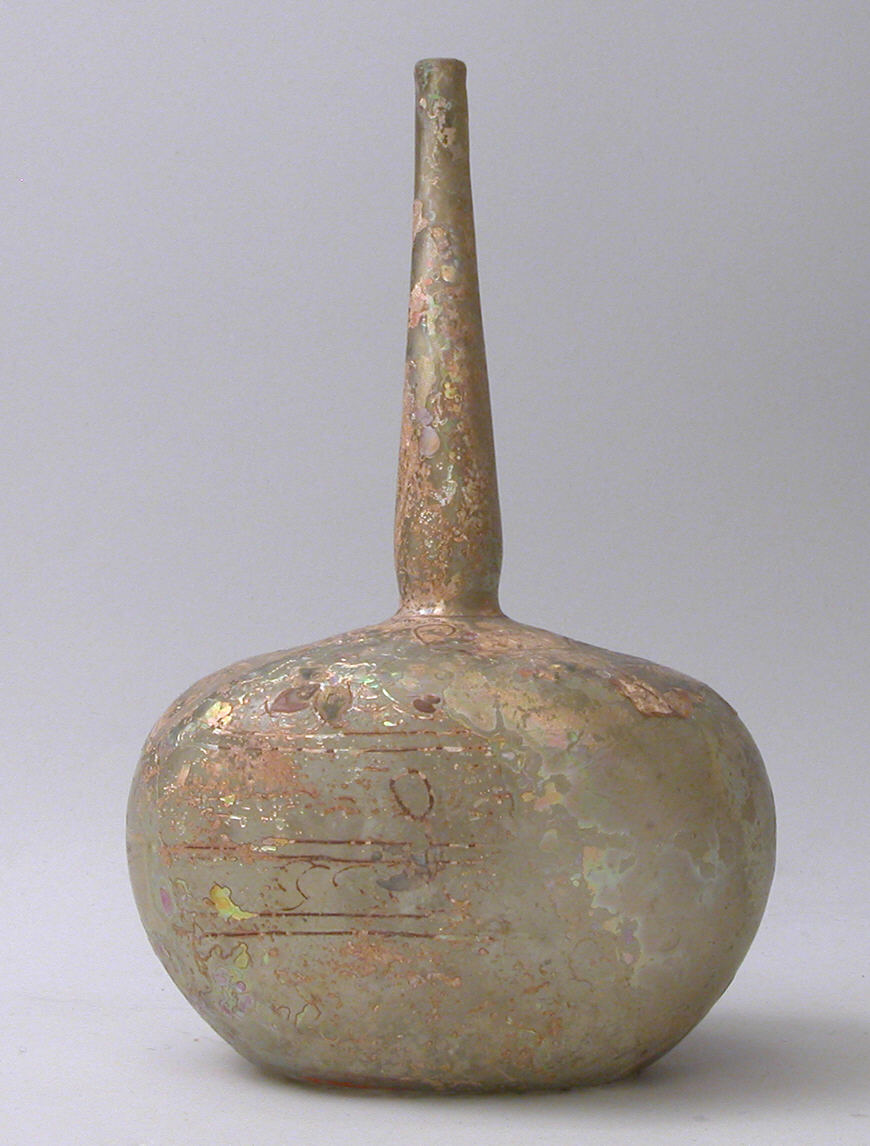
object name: bottle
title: Perfume Sprinkler [Qumqum] with Birds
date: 1301-1350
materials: glass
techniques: glassblowing, enamel, gilding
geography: egypt or syria